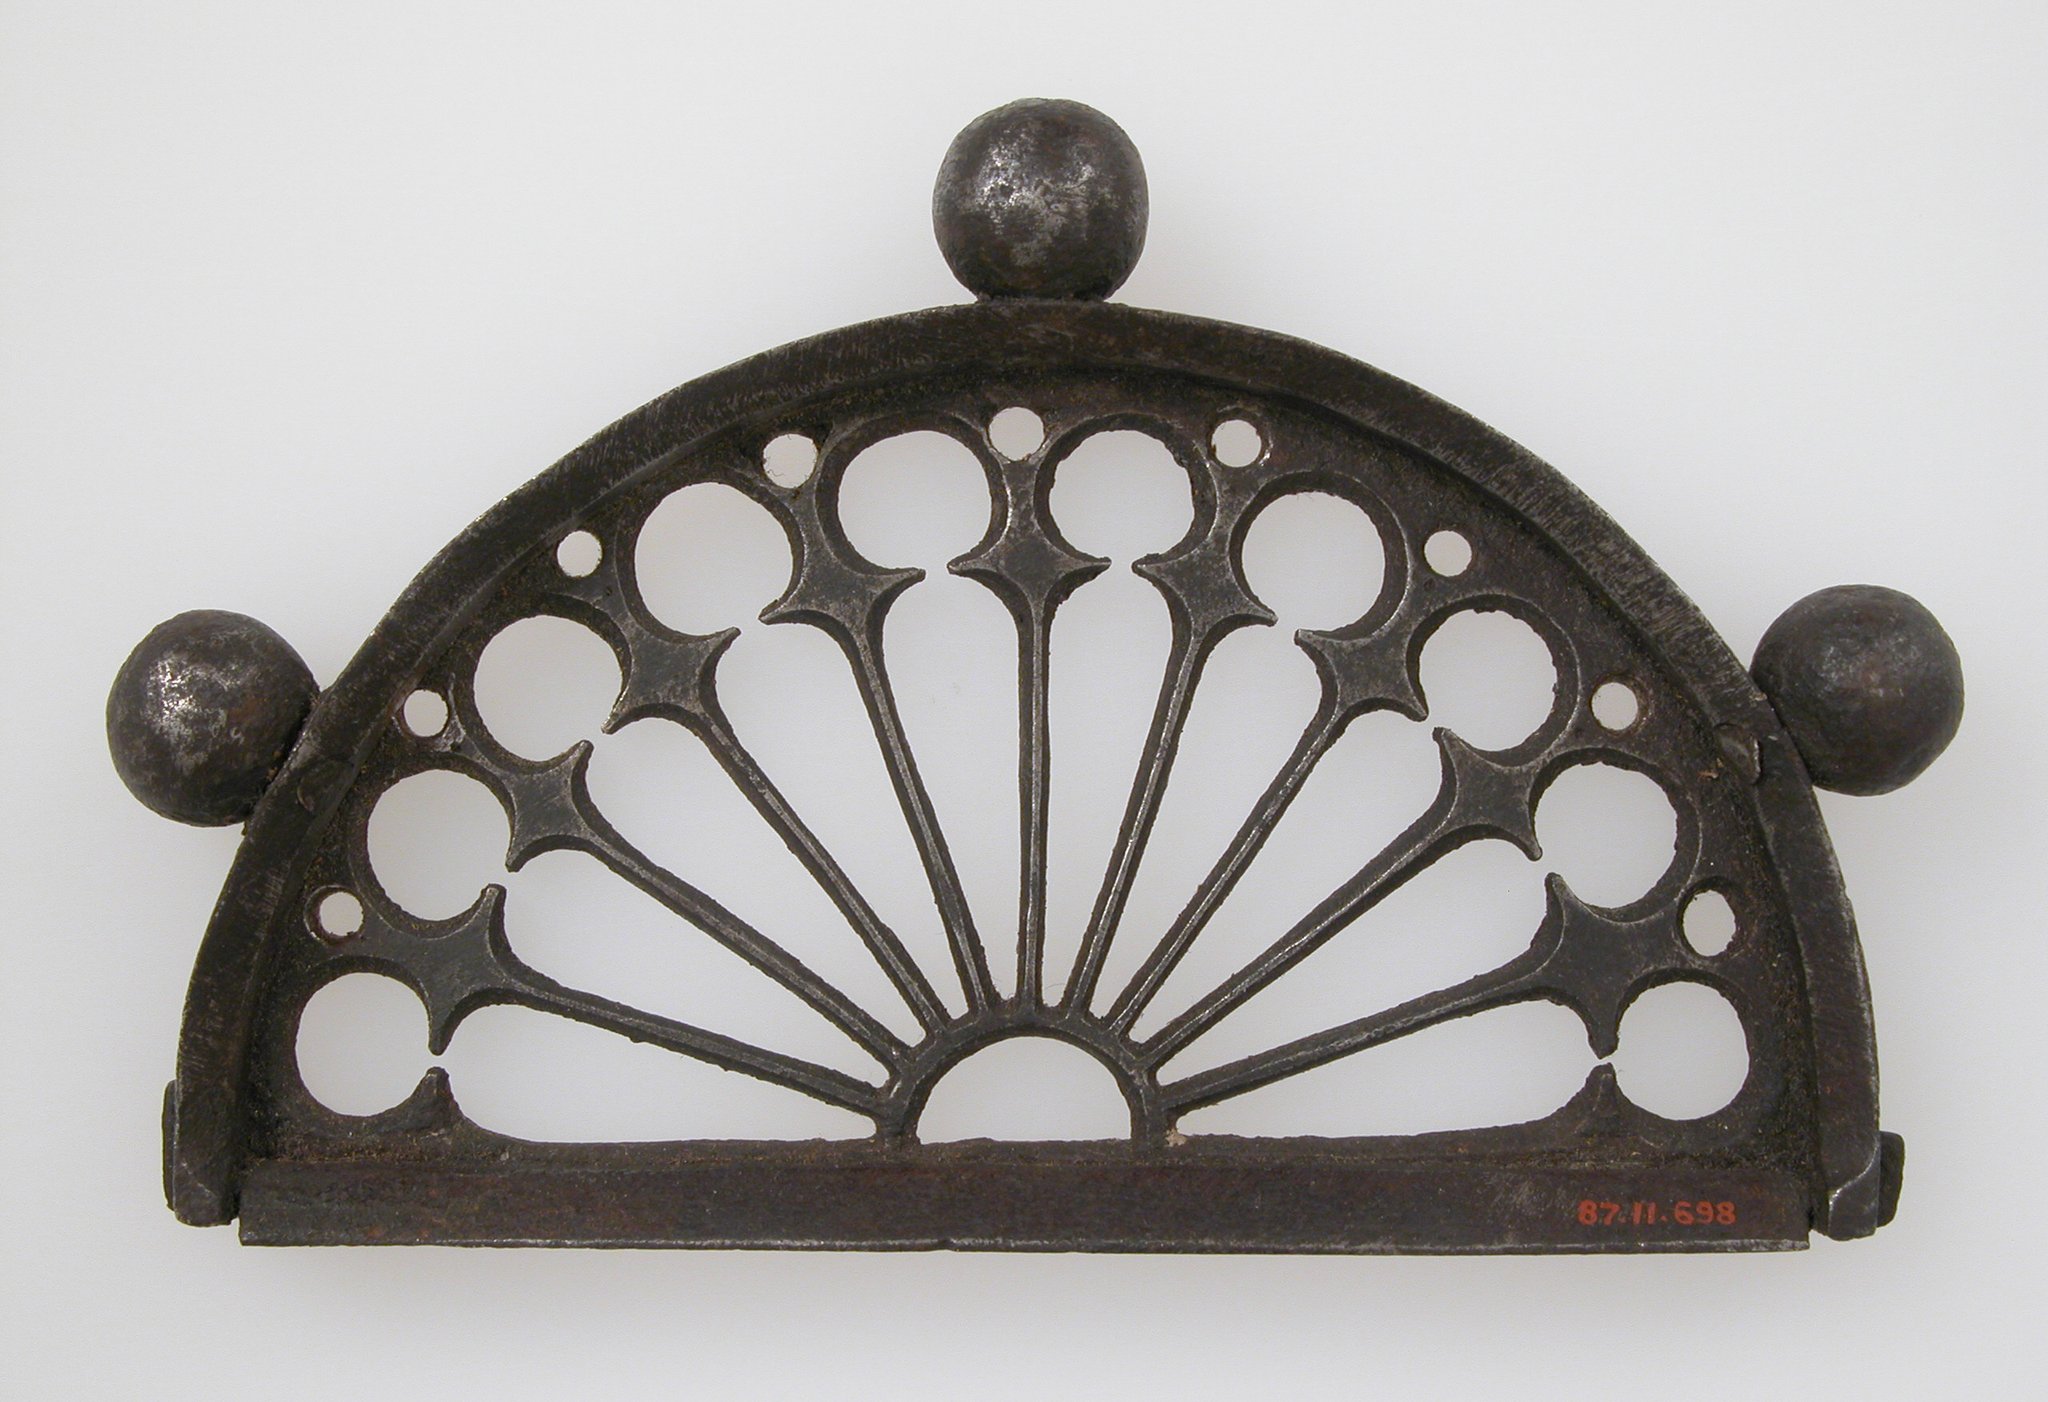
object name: fanlight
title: Fanlight (?)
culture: german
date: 1501-1600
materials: iron